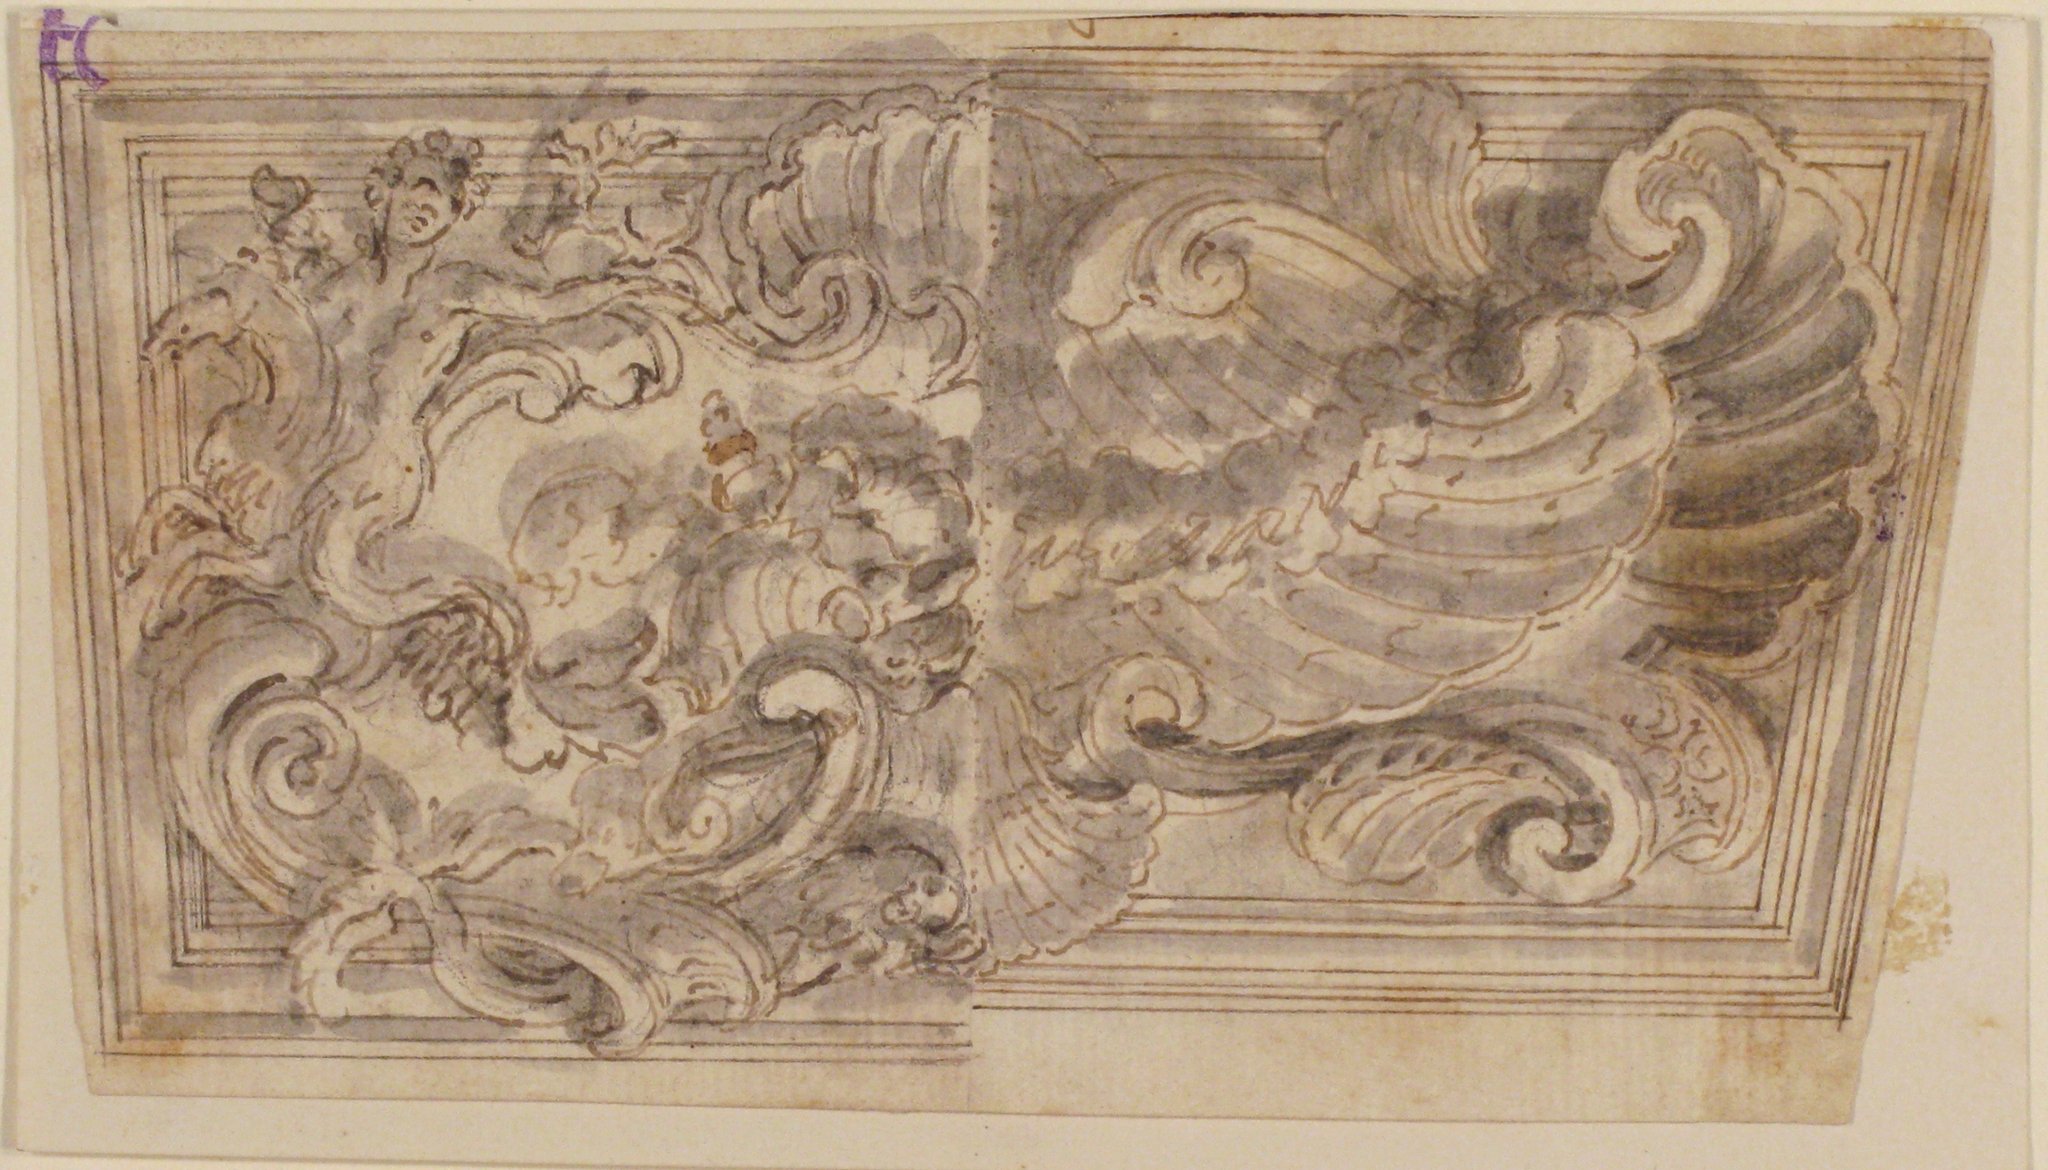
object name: drawing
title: Two Variants for the Design of a Horizontal Panel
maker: giovanni battista foggini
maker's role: artist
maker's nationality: italian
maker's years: 1652-1725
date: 1672-1725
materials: chalk, ink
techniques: brush, pen, wash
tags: ornament